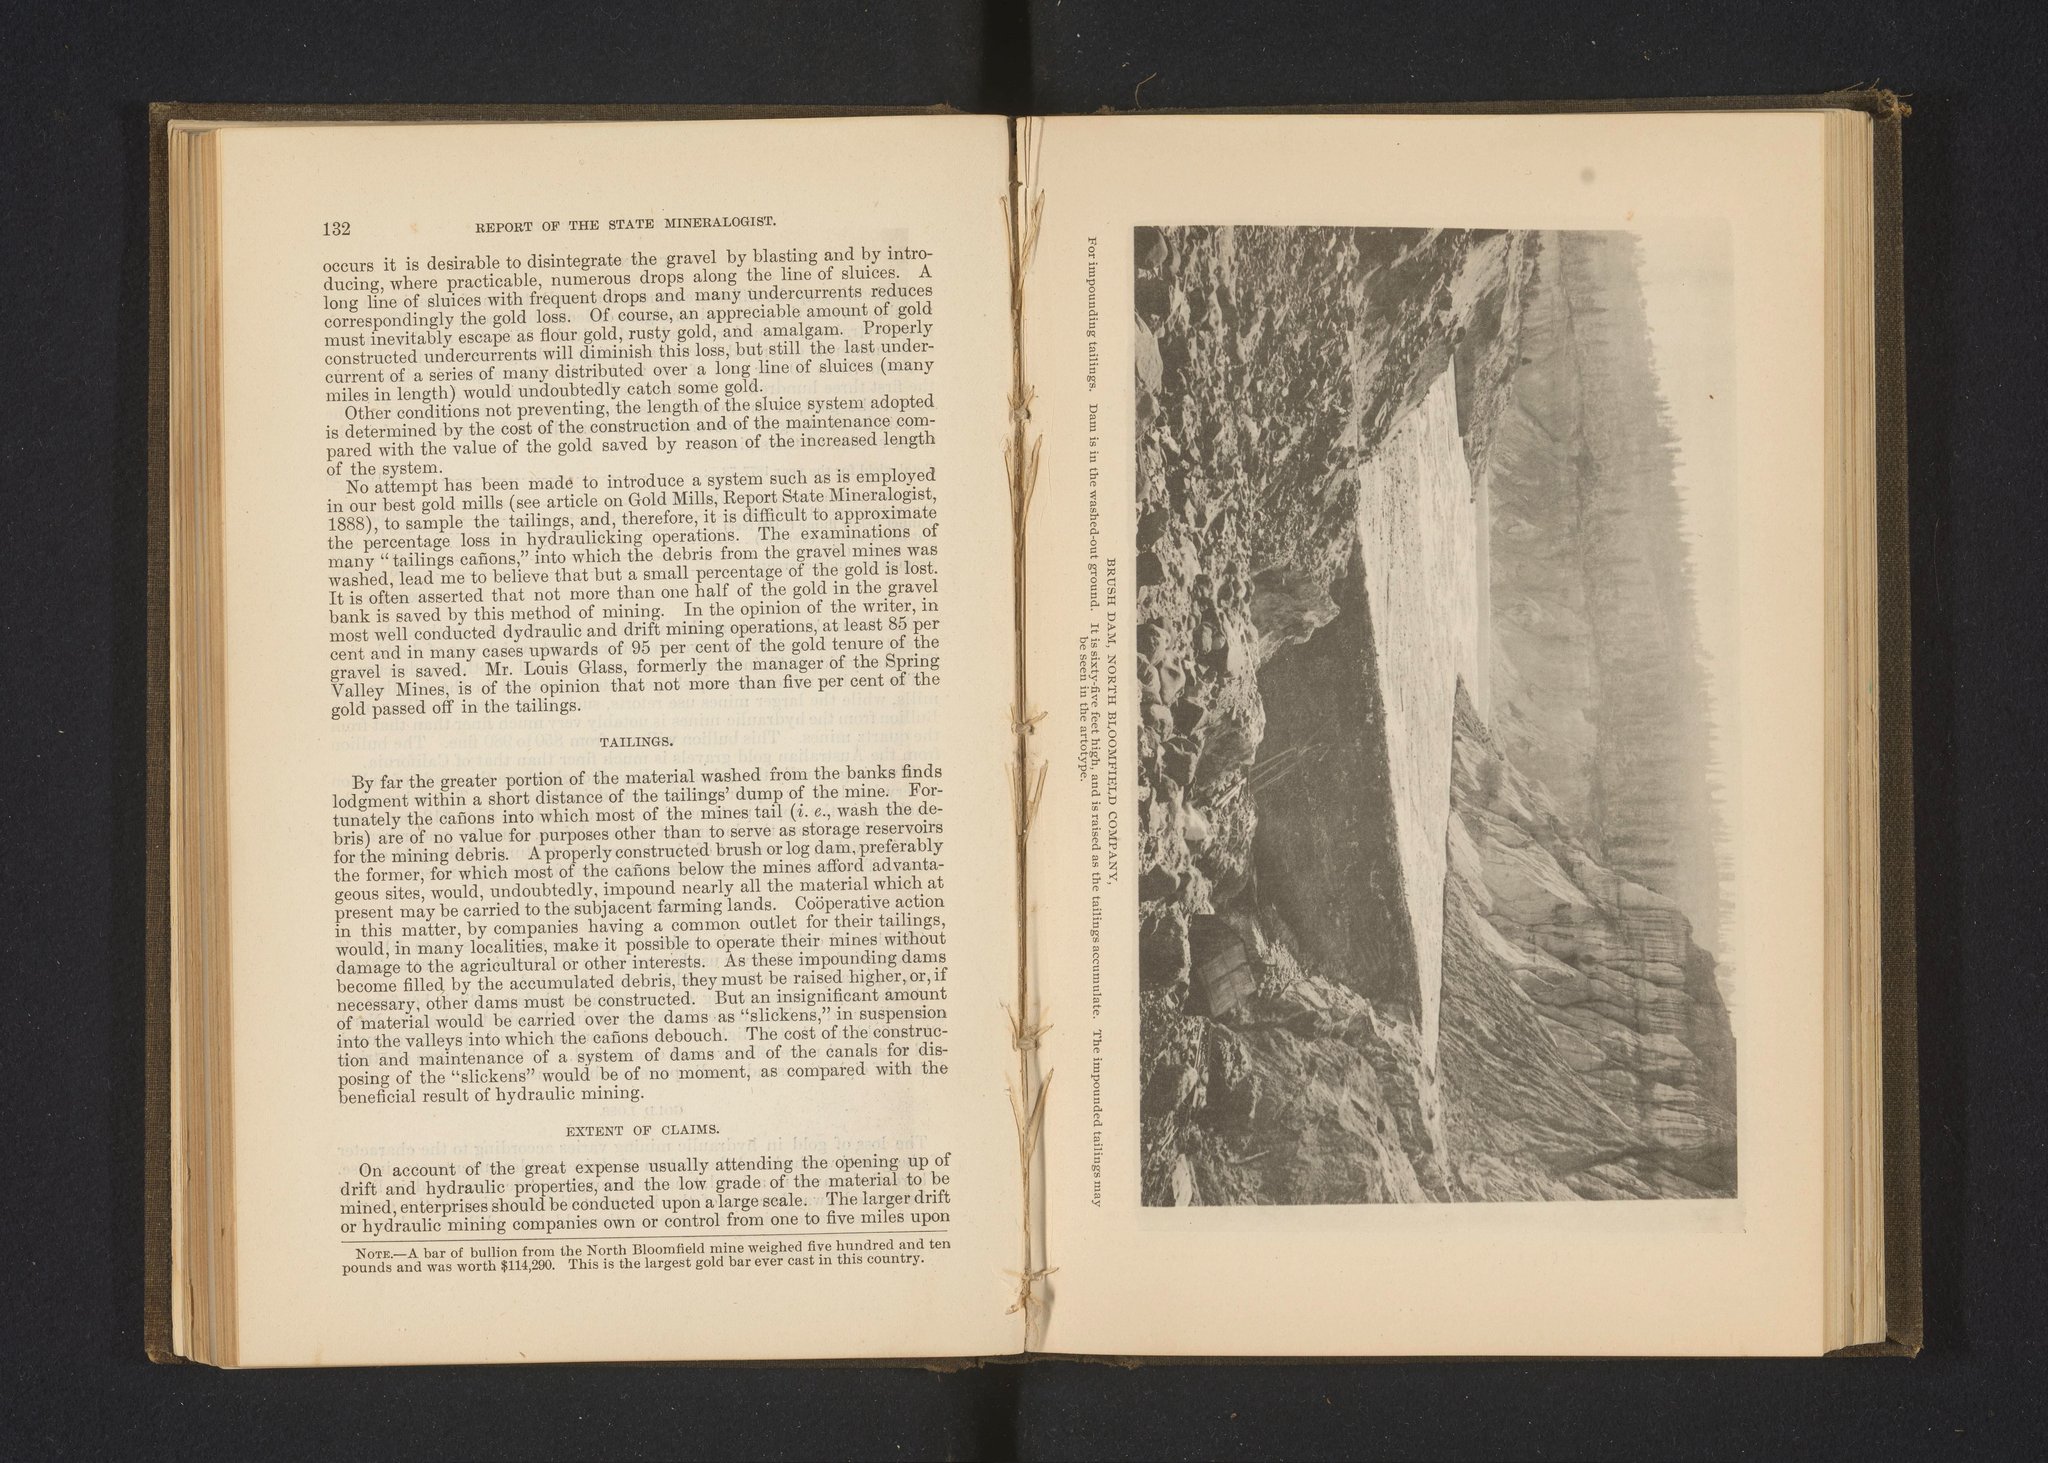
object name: photomechanical print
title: Gezicht op Brush Dam in North Bloomfield, Californië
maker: Anonymous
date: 1885-1890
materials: paper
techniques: photograph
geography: north bloomfield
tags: mine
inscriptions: inscription: ‘For impounding tailings. Dam is in the washed-out ground. It is sixty-five feet high, and is raised as the tailings accumulate. The impounded tailings may/ be seen in the artotype.’